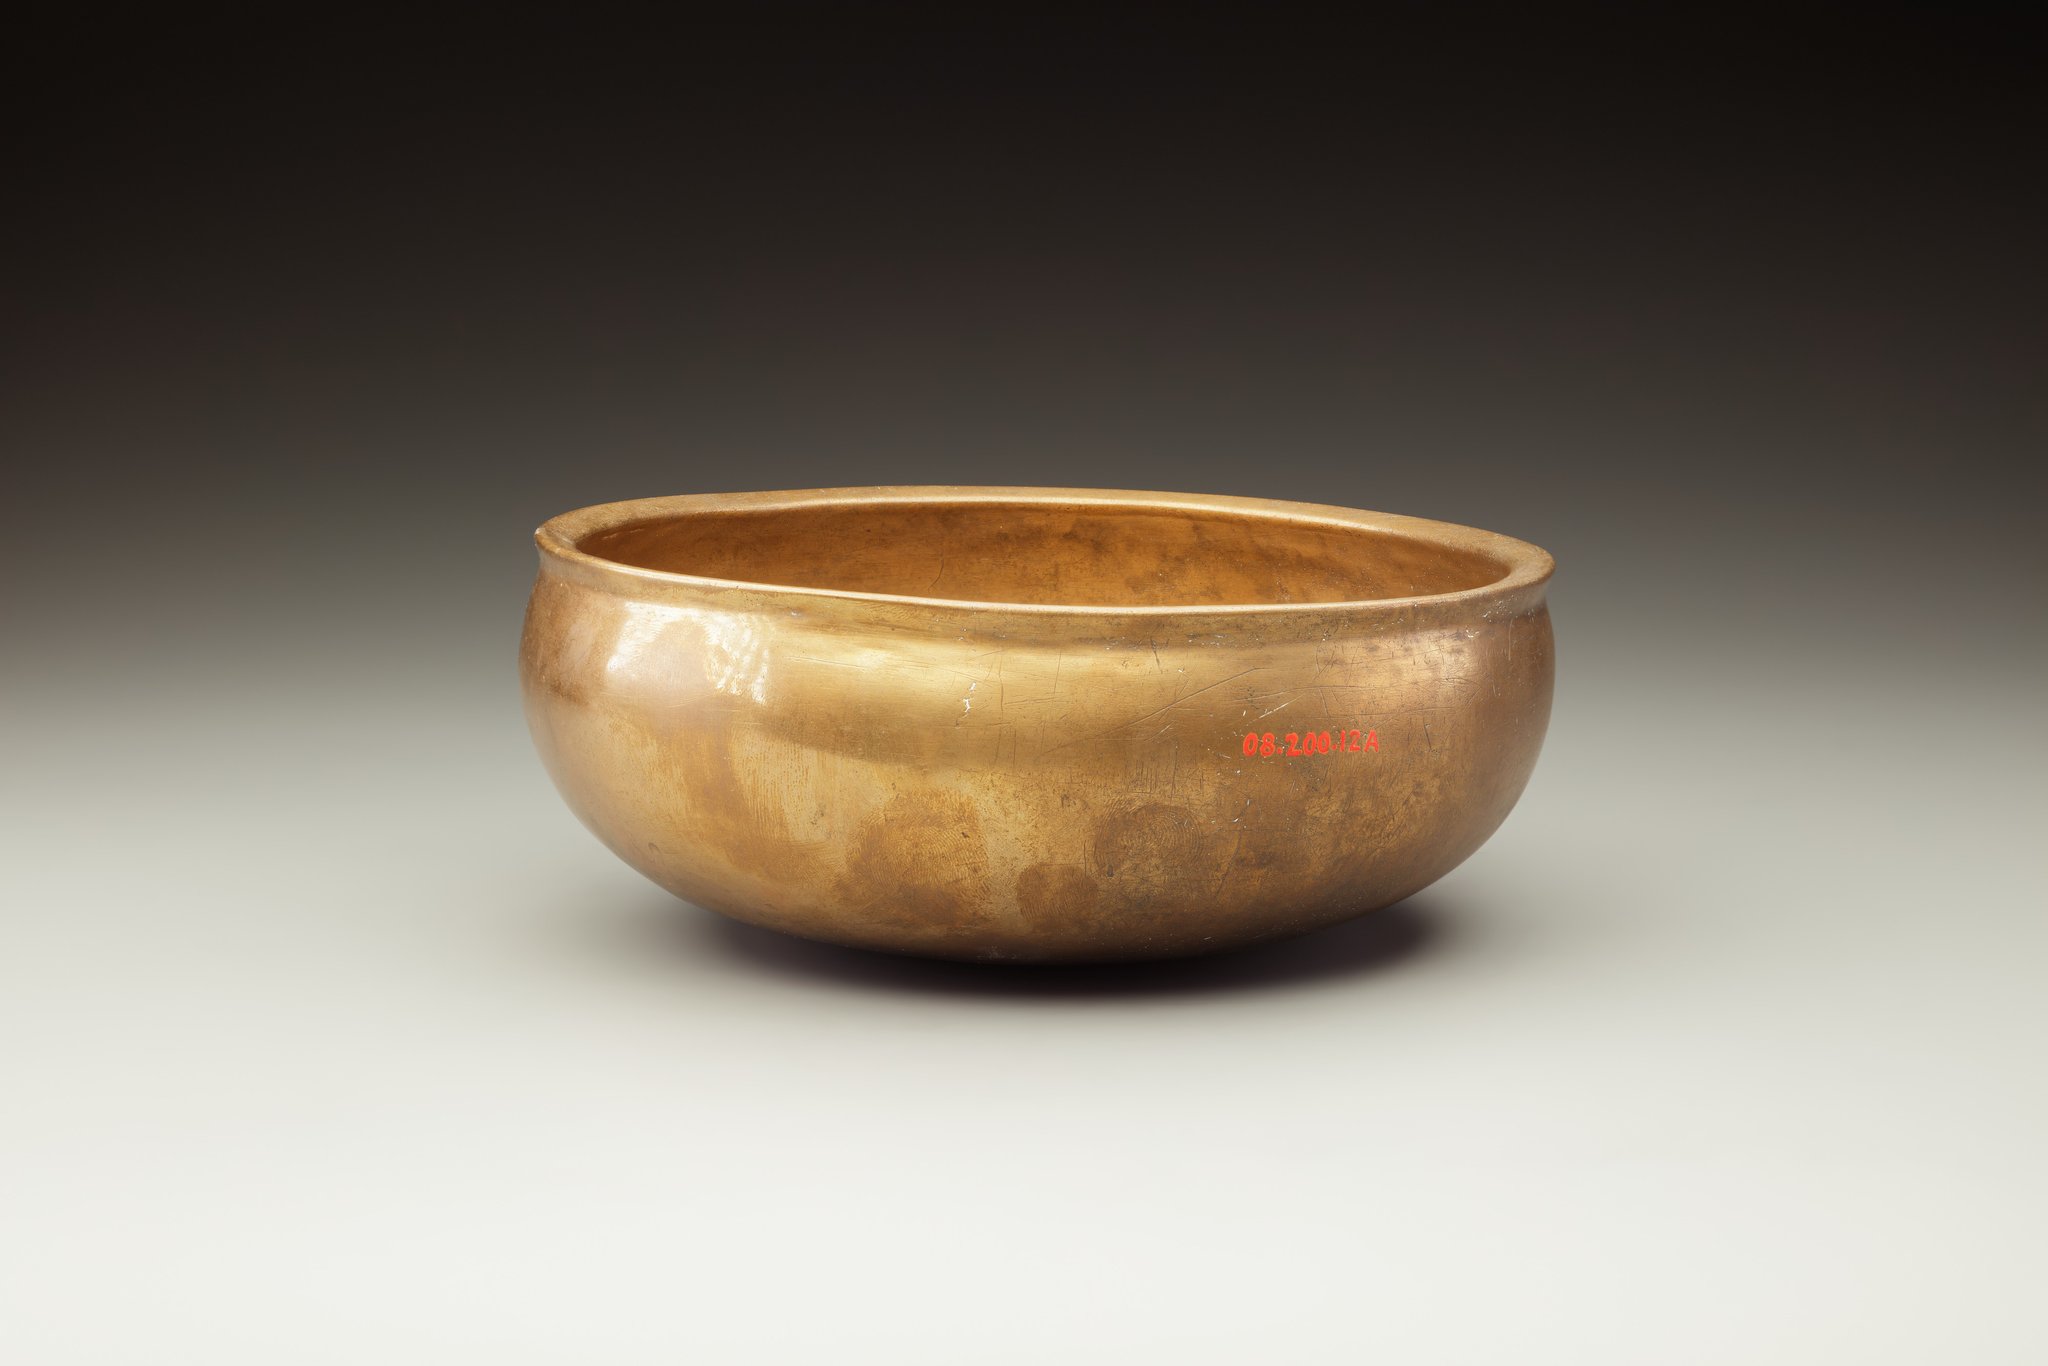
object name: bowl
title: One of five bowls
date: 1295-1070 BCE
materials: bronze, copper alloy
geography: egypt